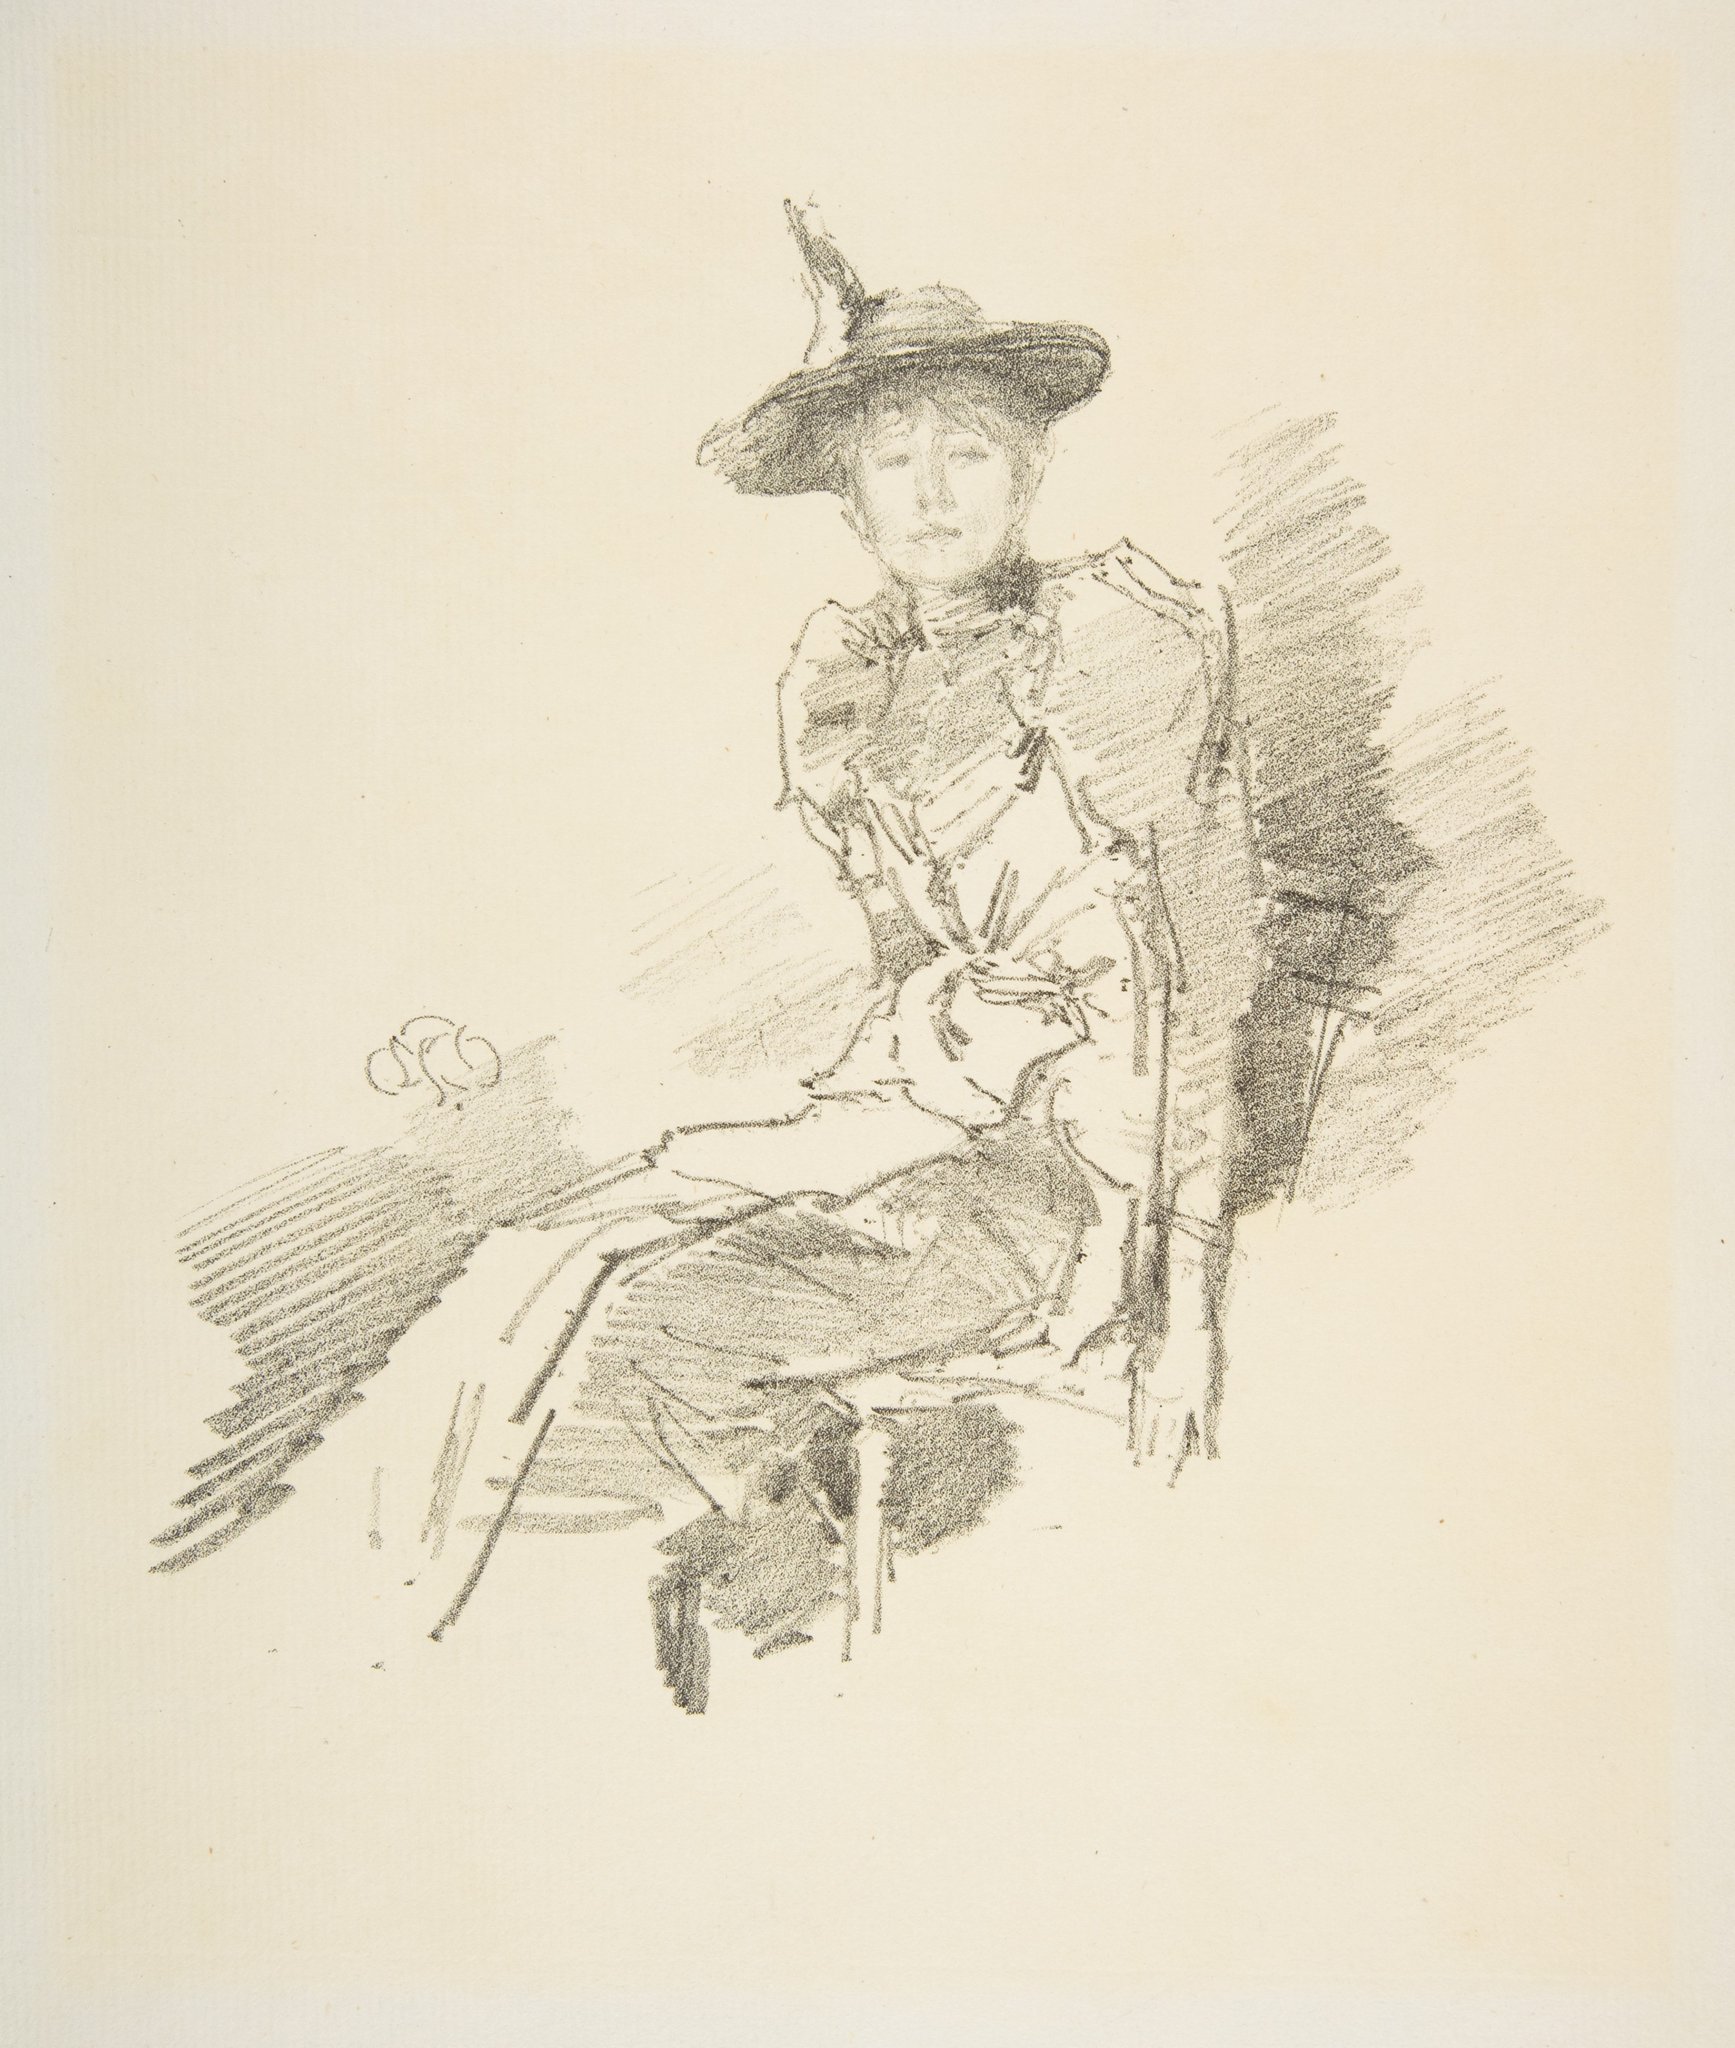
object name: print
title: The Winged Hat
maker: james mcneill whistler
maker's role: artist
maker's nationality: american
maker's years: 1834-1903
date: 1890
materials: ink, paper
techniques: printing, lithography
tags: hats,women